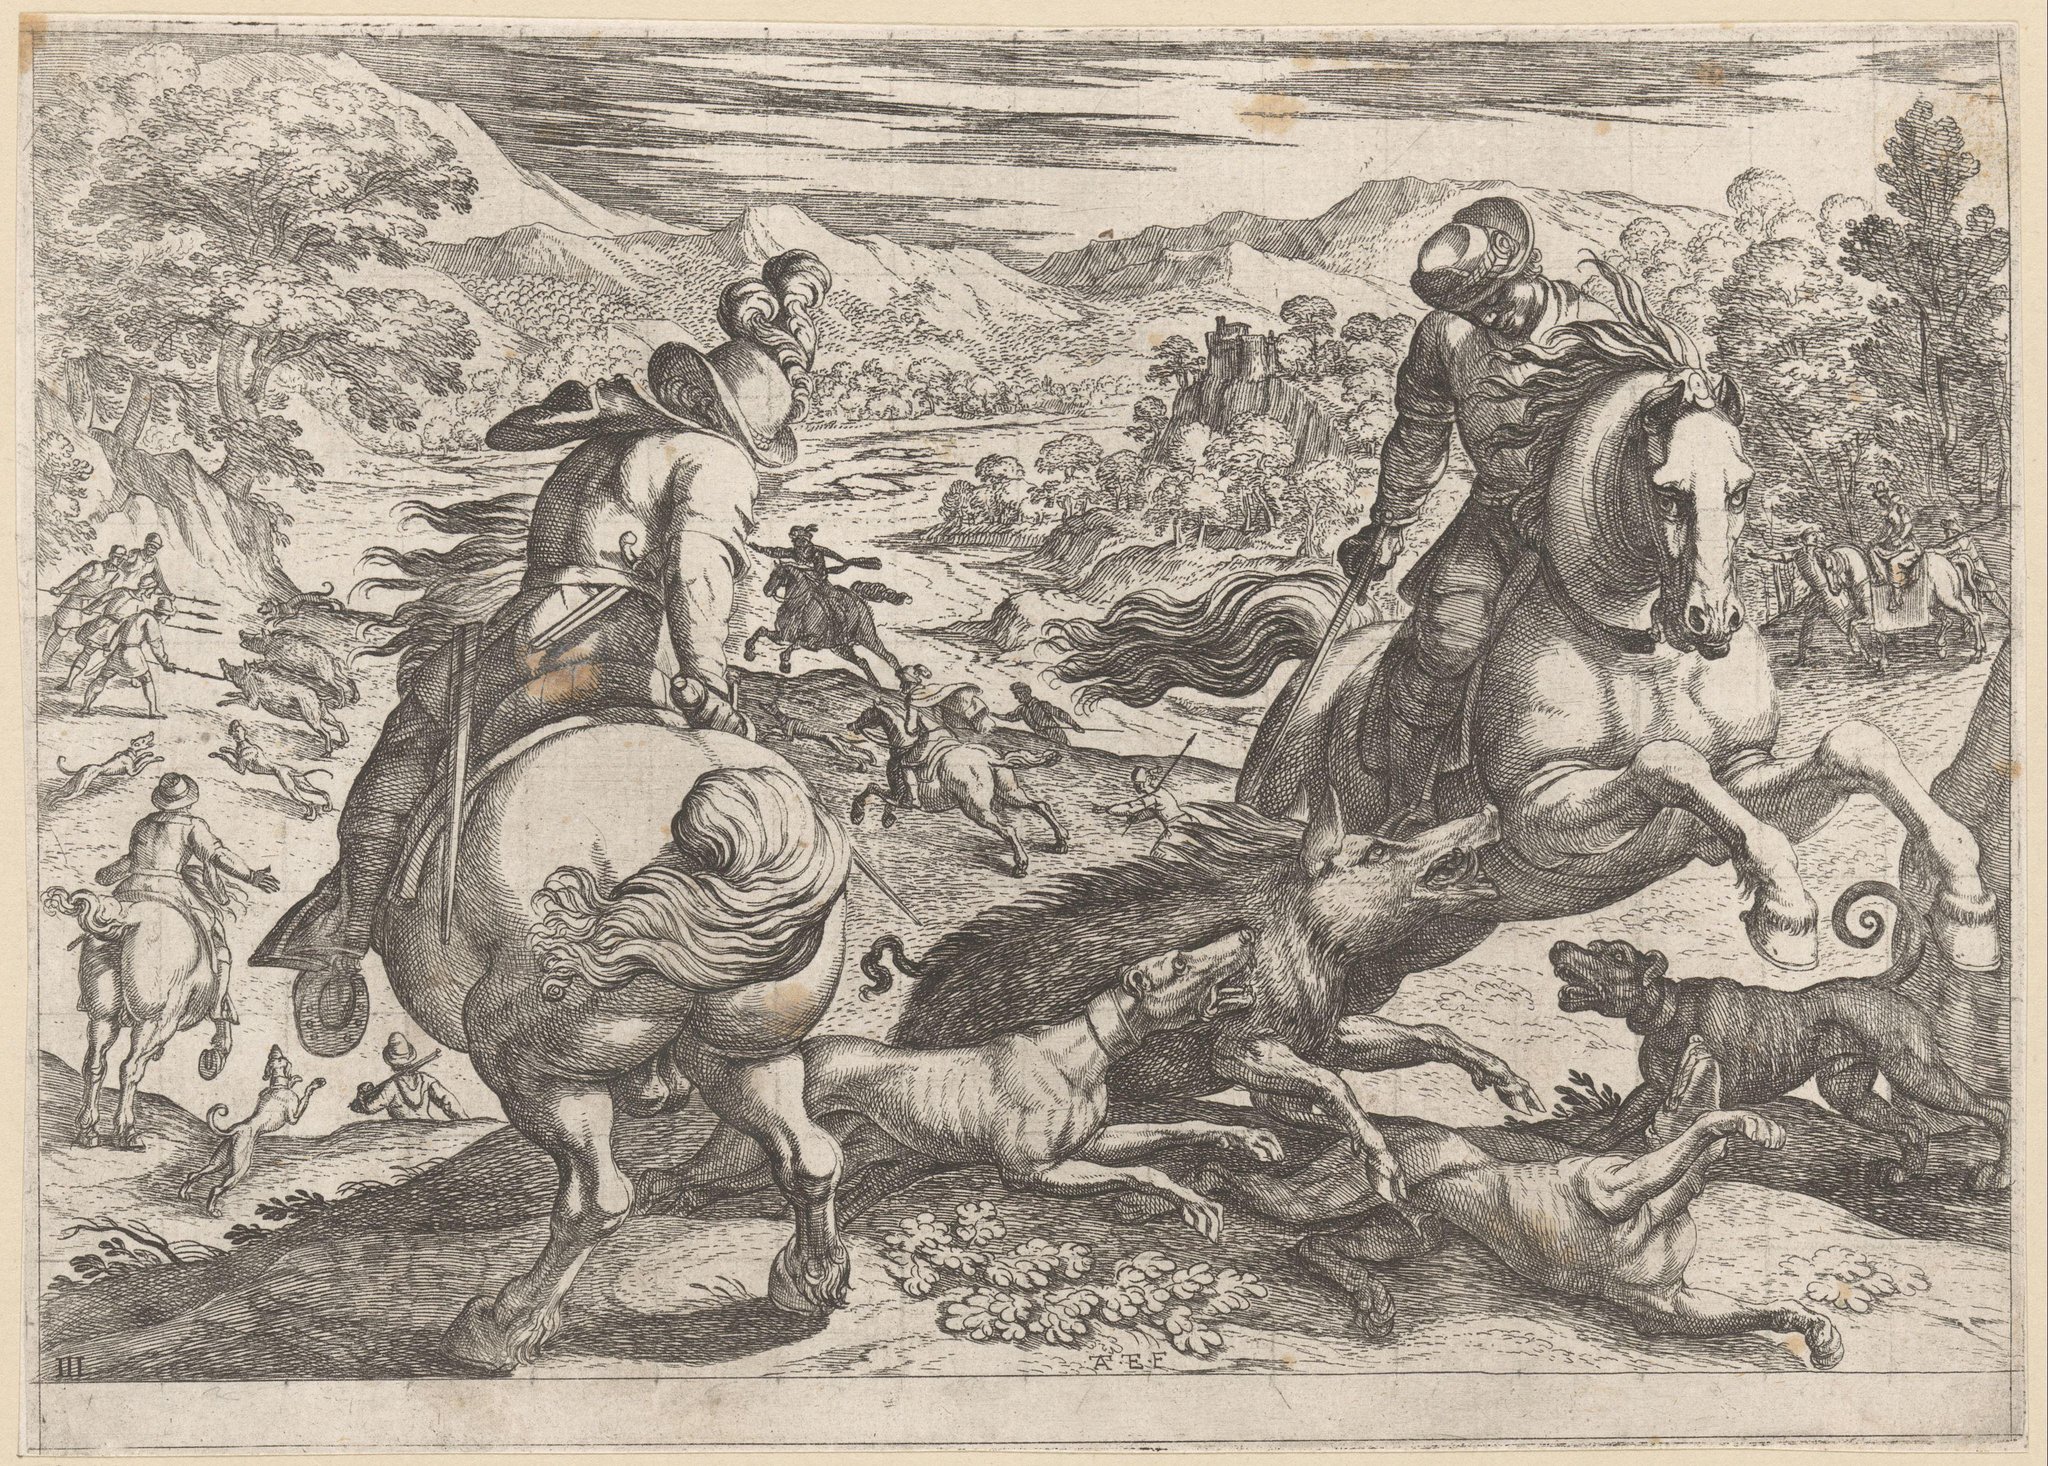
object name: print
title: Jacht op everzwijnen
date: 1609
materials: paper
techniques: etching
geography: rome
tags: boar-hunting, hunter, hunters hunting (n.b.: in 1988-1990 this notation denoted the concept of 43c11421 'hunters resting during the hunt')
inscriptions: collector's mark: Lugt 240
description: Deze prent maakt deel uit van een reeks van negen prenten met jachtscènes (+ opdracht).